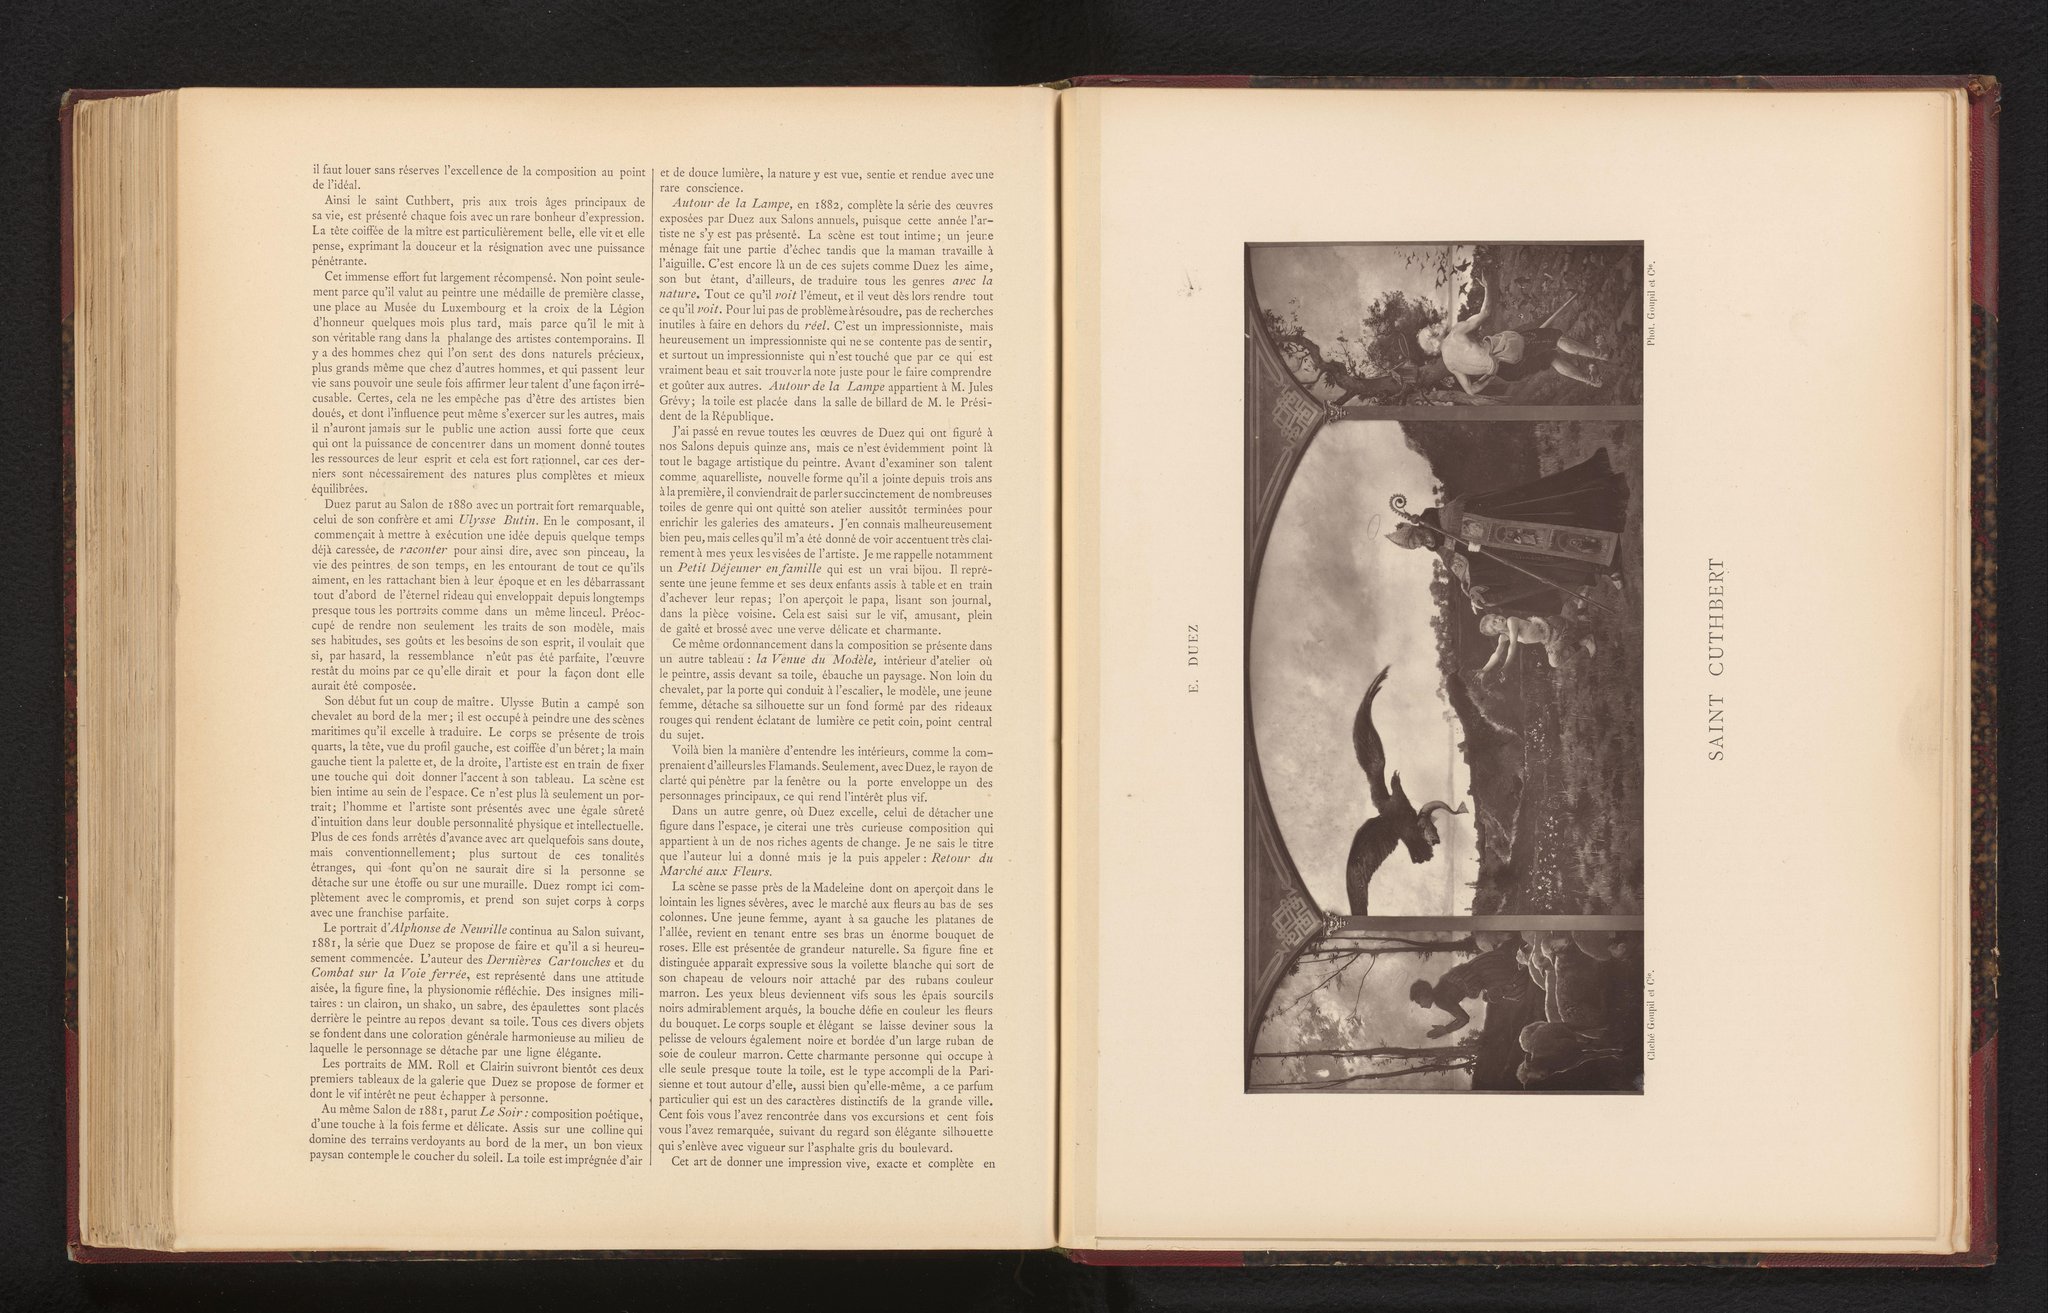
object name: photomechanical print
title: Fotoreproductie van het schilderij 'Saint Cuthbert' door Ernest-Ange Duez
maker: ernest-ange duez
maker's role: painter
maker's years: 1843-1896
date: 1878-1883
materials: paper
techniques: woodburytype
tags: saints